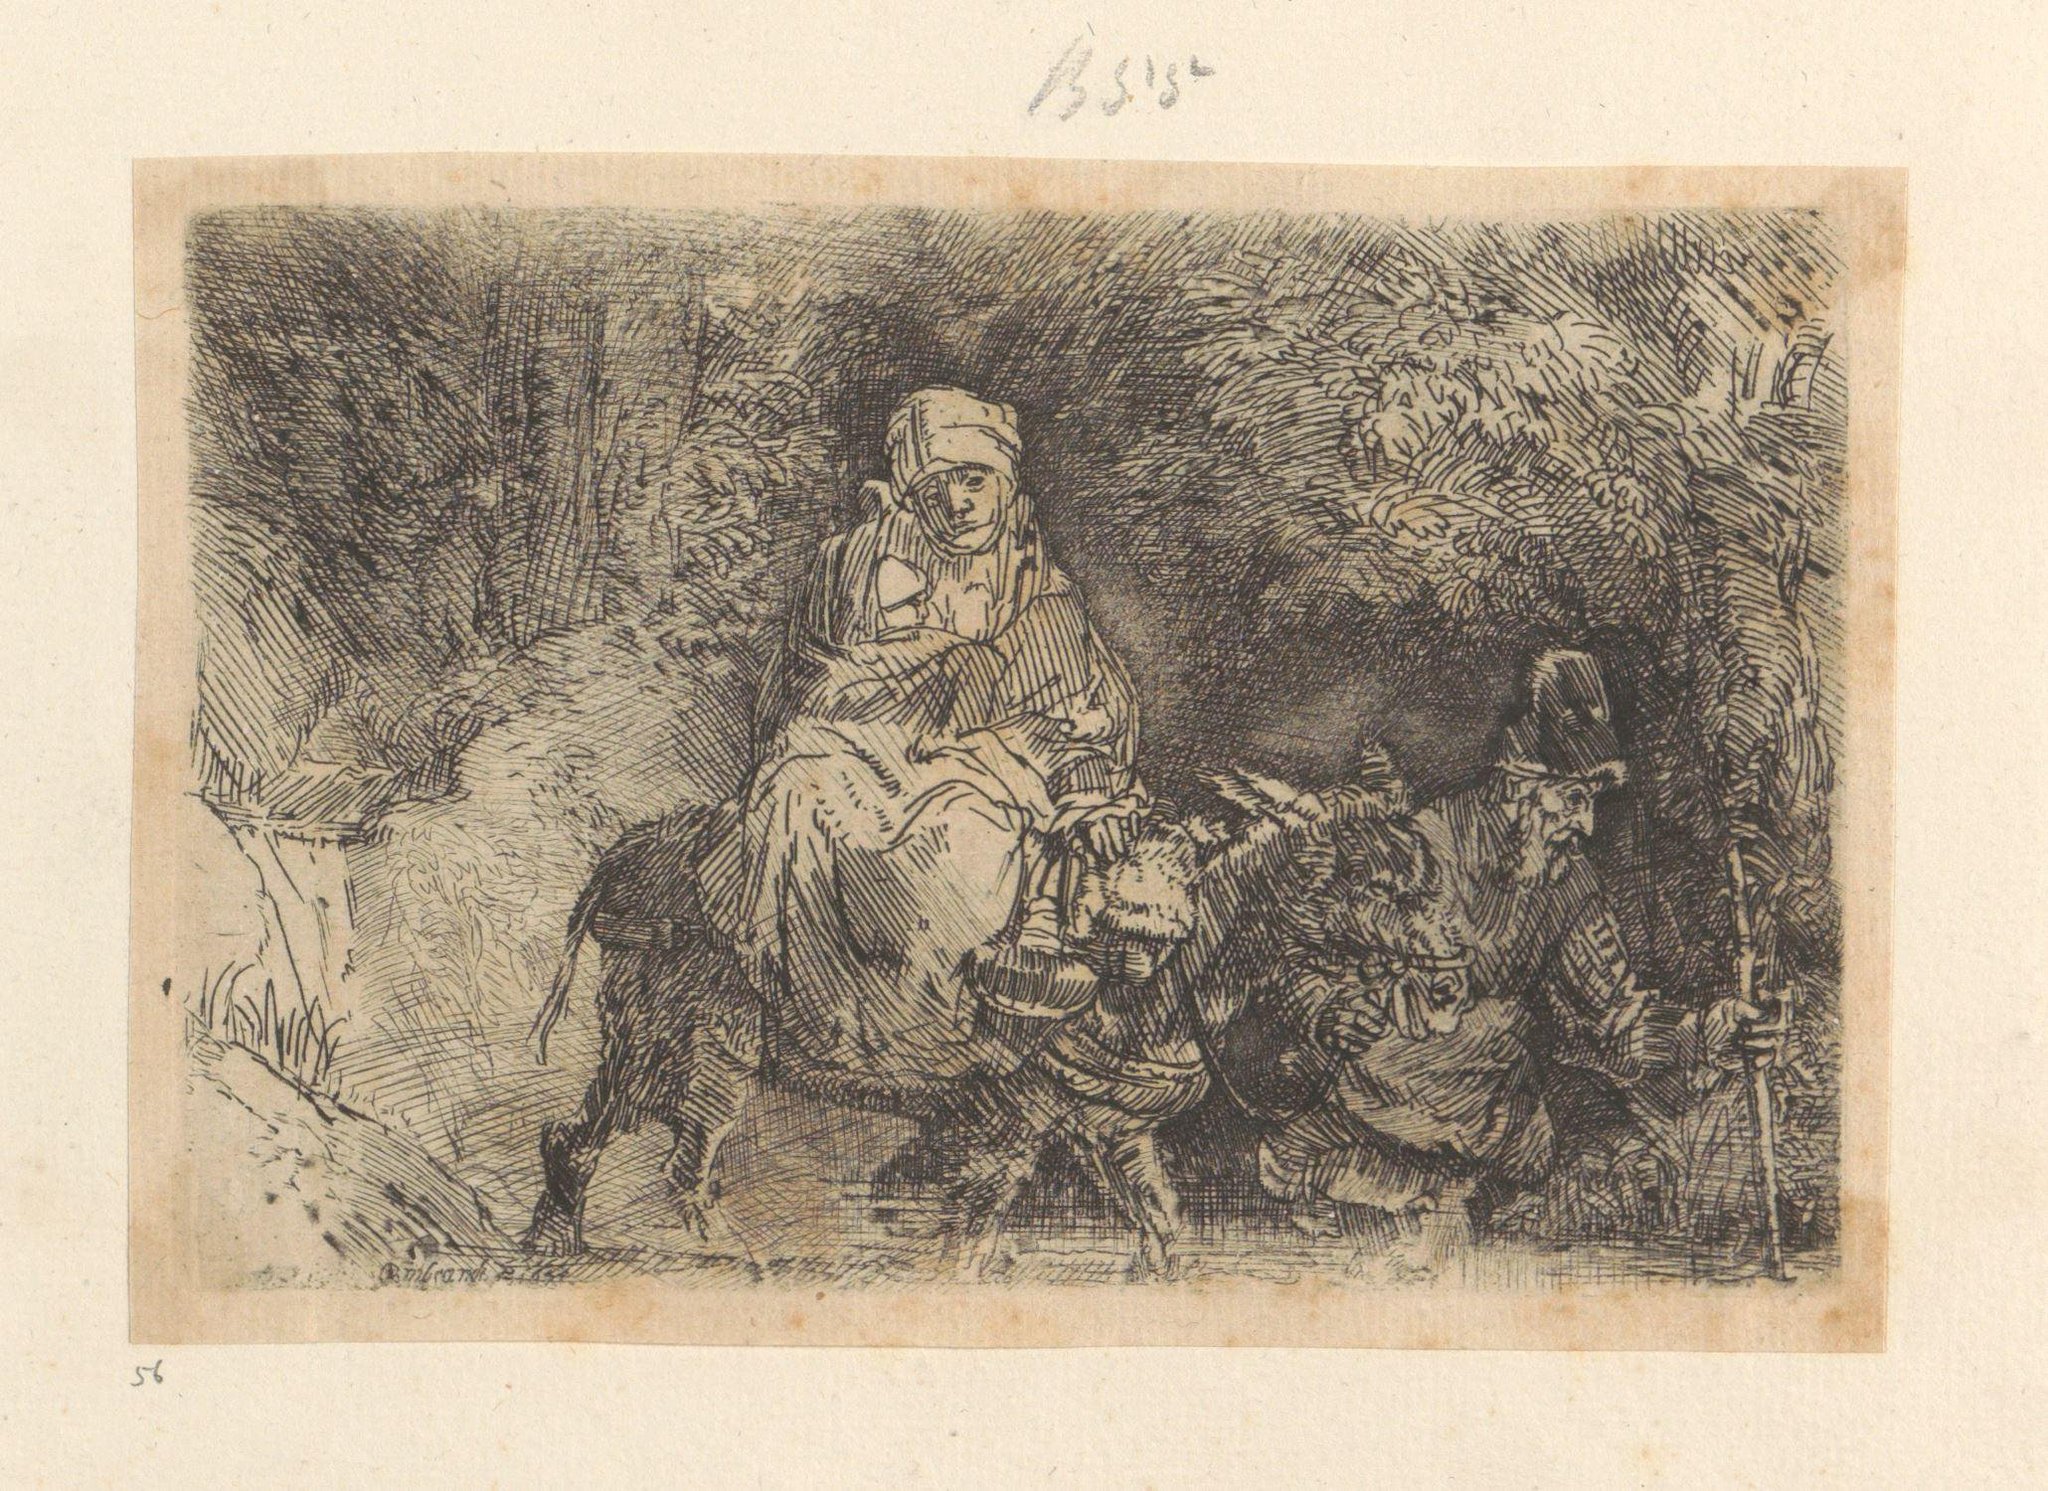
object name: print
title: Vlucht naar Egypte: het oversteken van een beek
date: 1654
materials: paper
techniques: drypoint, engraving, etching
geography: paris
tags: the flight into egypt: mary, joseph, the child (and sometimes others) on their way; mary usually riding on an ass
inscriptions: date